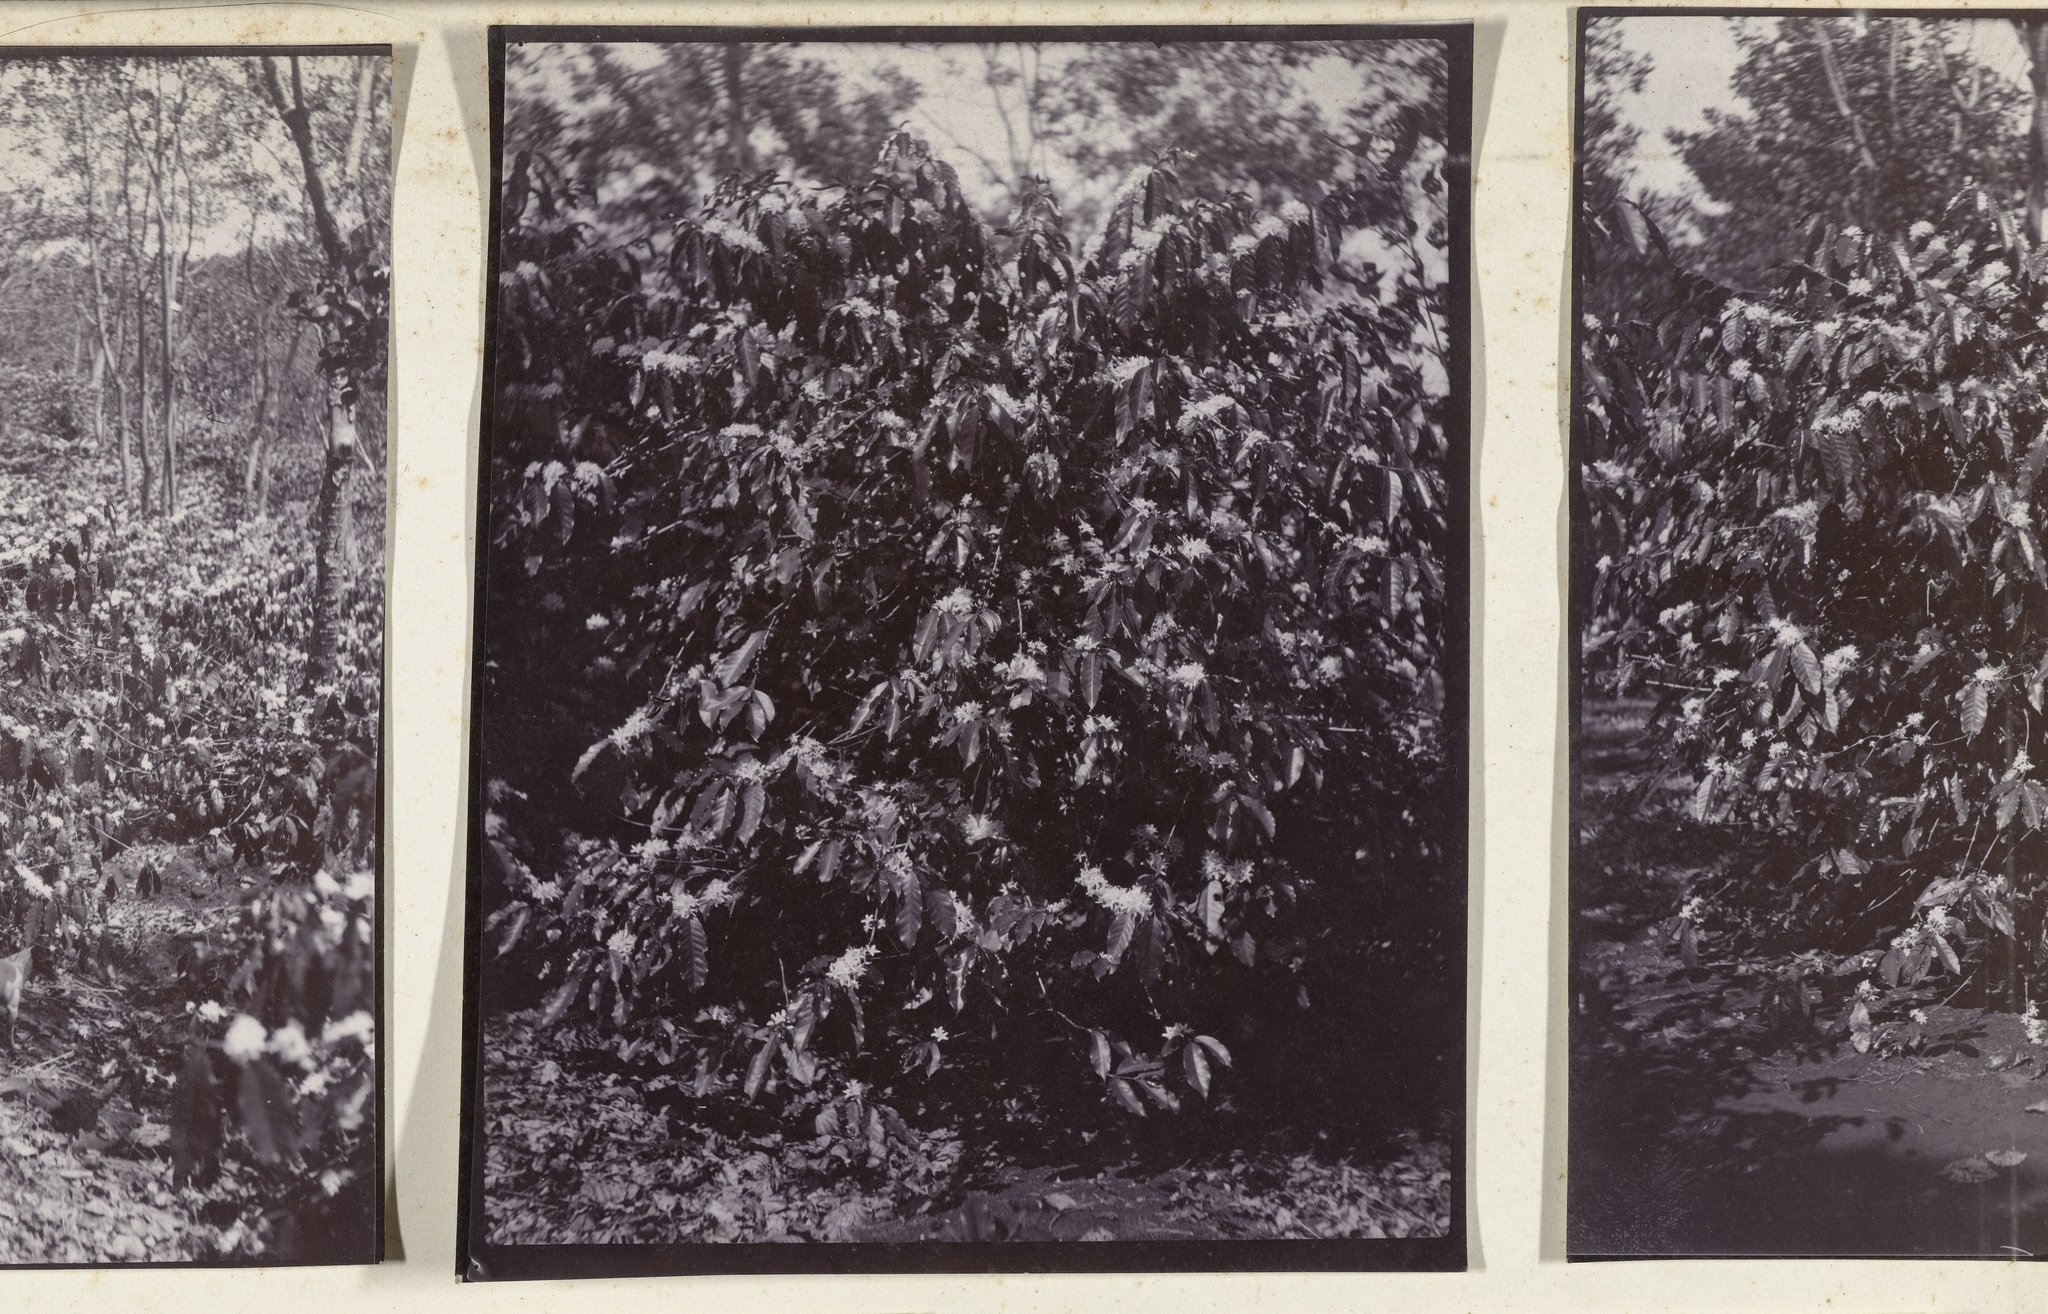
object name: photograph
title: Koffietuinen van Silo Sanen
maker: Anonymous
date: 1890-1910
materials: cardboard, paper, photographic support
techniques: gelatin silver print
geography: netherlands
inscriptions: caption: ‘Koffietuinen van Silo Sanen’